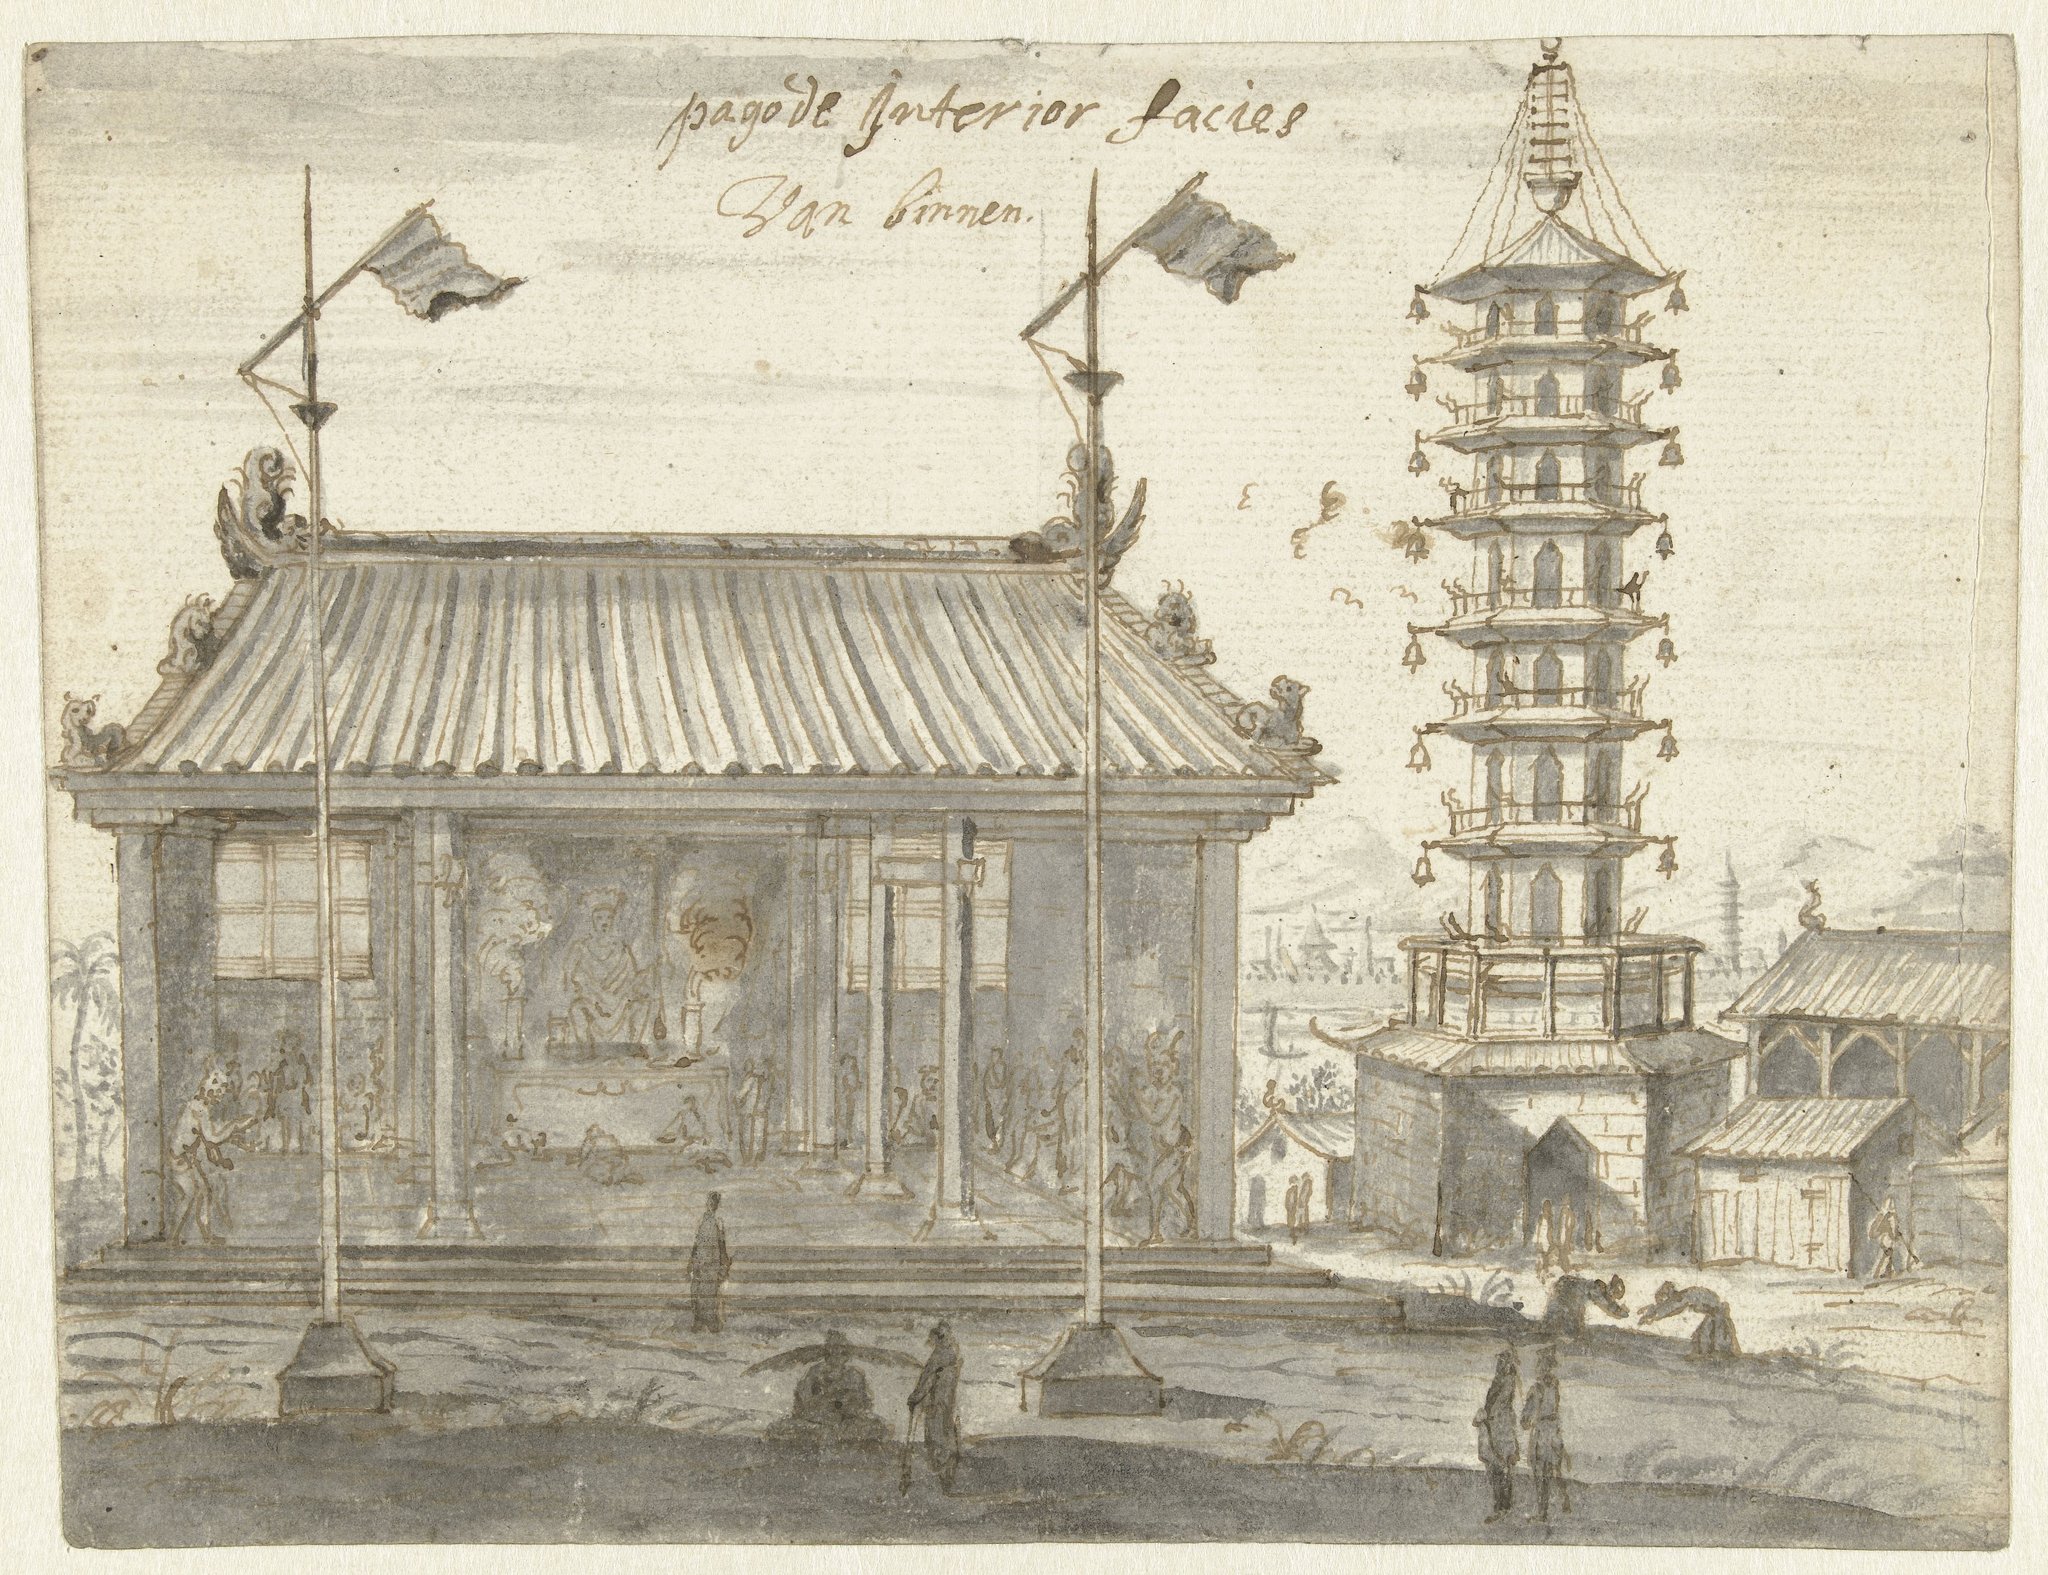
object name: drawing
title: Chinese temple and pagoda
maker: joan nieuhof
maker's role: draughtsman, traveler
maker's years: 1618-1672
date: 1655-1657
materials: paper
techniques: brush, pen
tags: temple, shrine ~ hinduism, buddhism, jainism, chinese, temple, shrine ~ non-christian religions